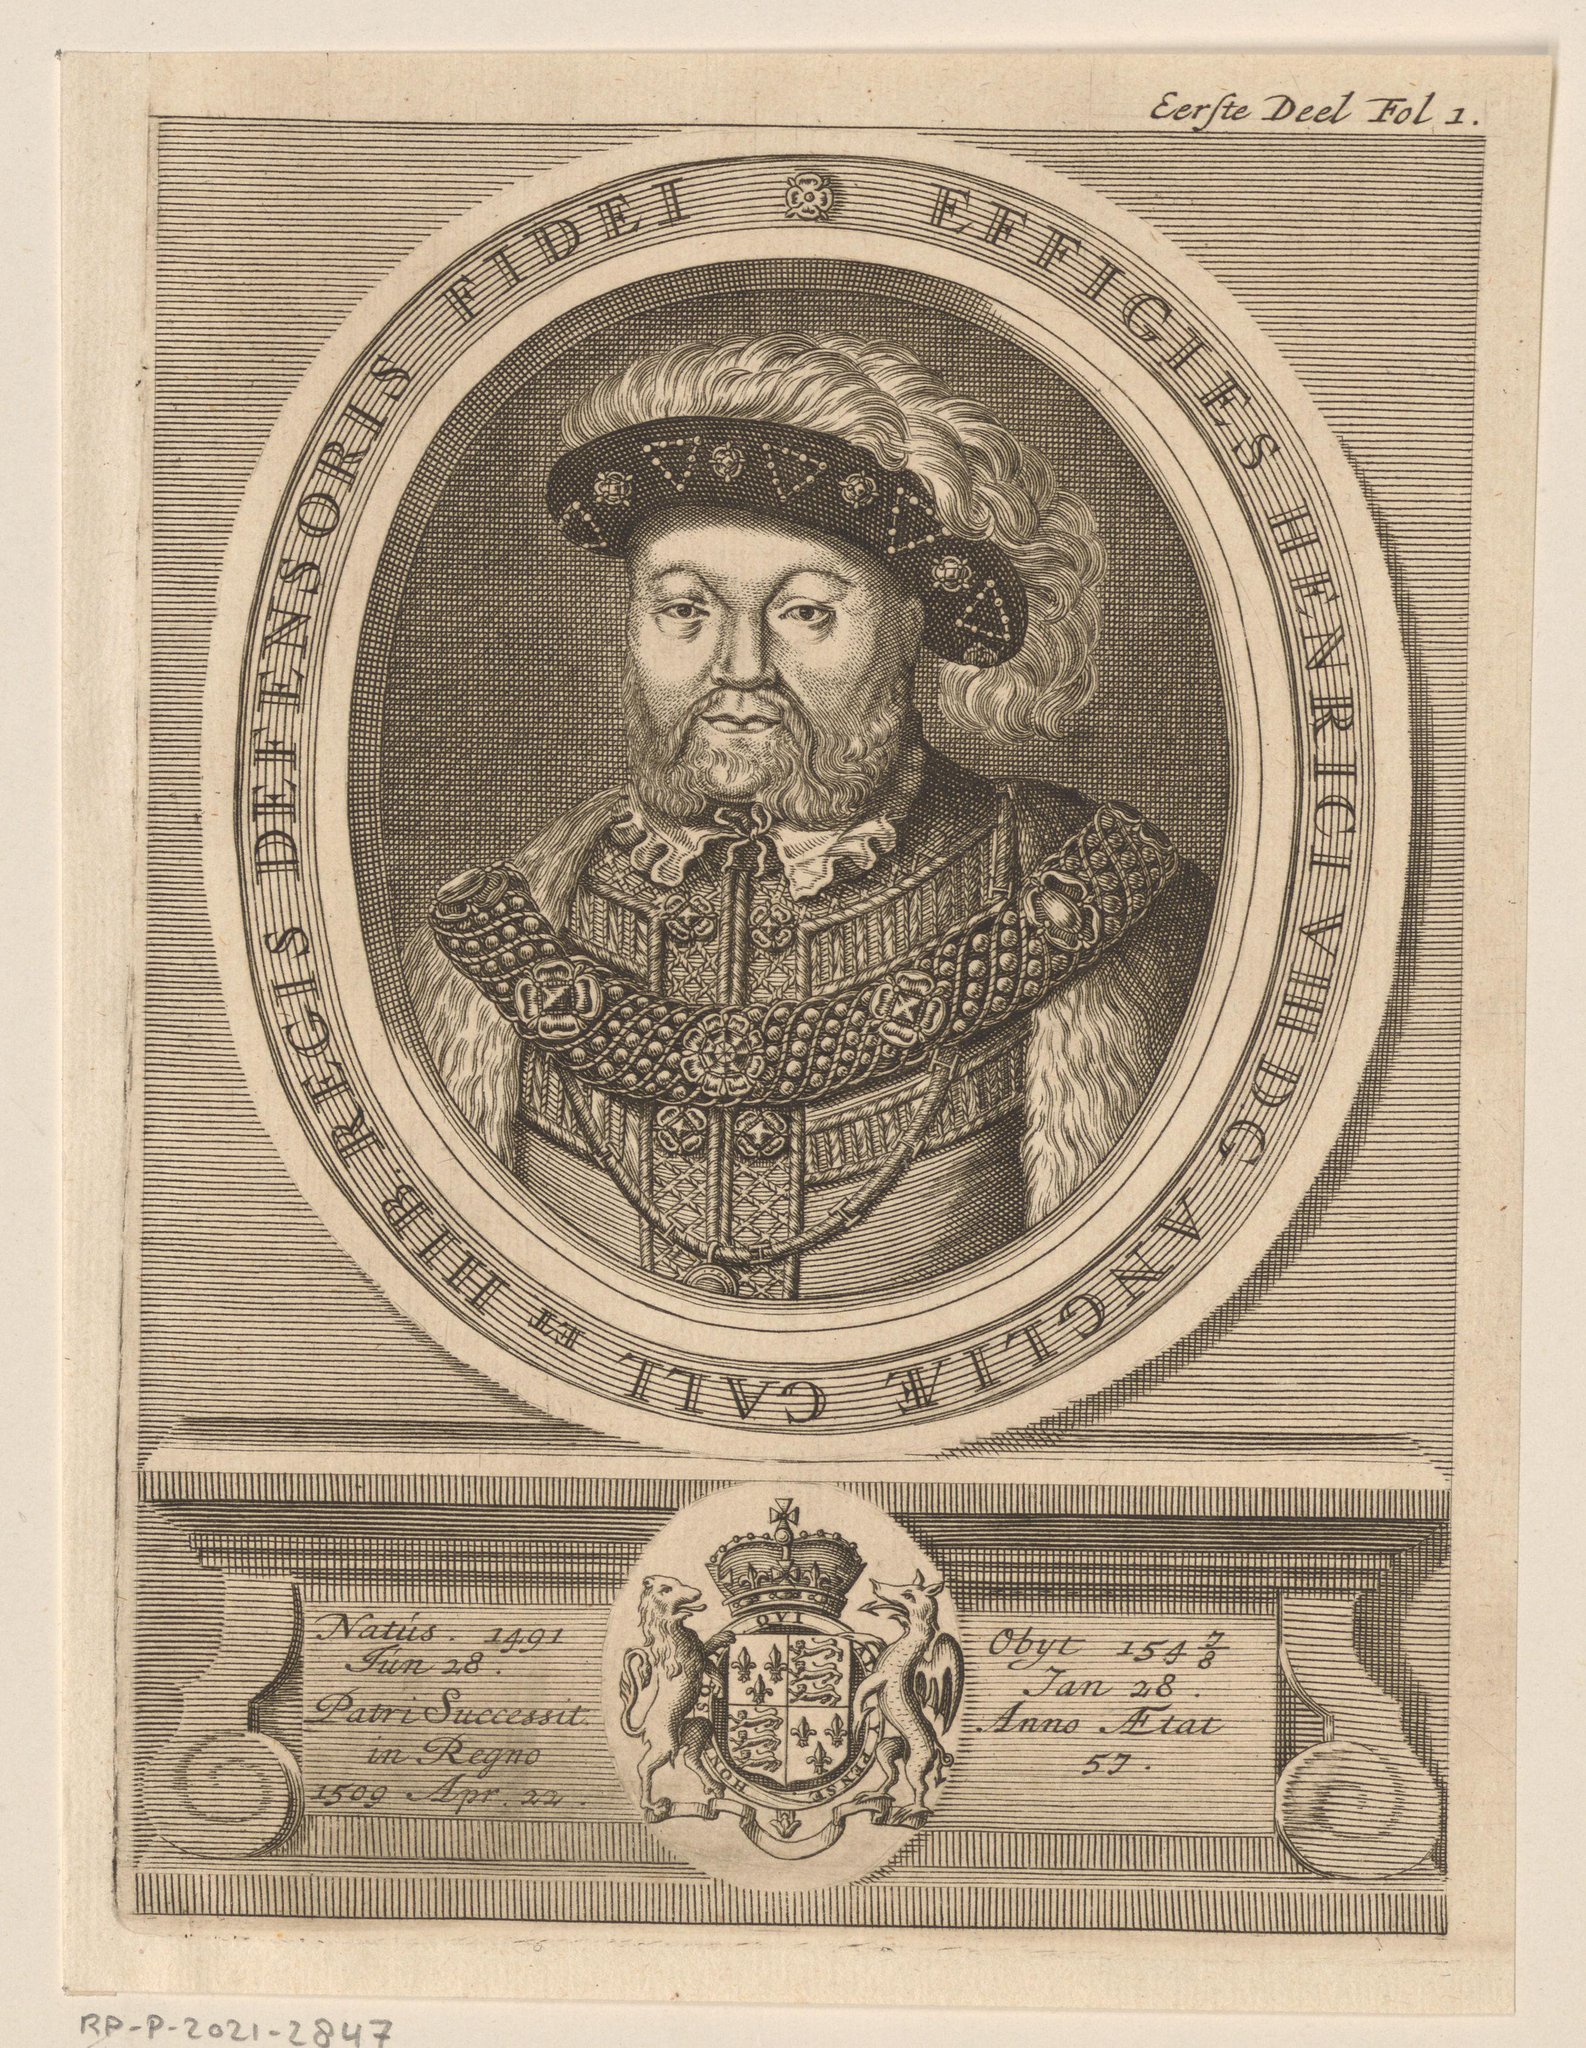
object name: print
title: Portret van Hendrik VIII, koning van Engeland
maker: Anonymous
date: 1650-1749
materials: paper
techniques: engraving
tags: historical persons, king, armorial bearing, heraldry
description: Rechtsboven genummerd: Eerste Deel Fol 1.